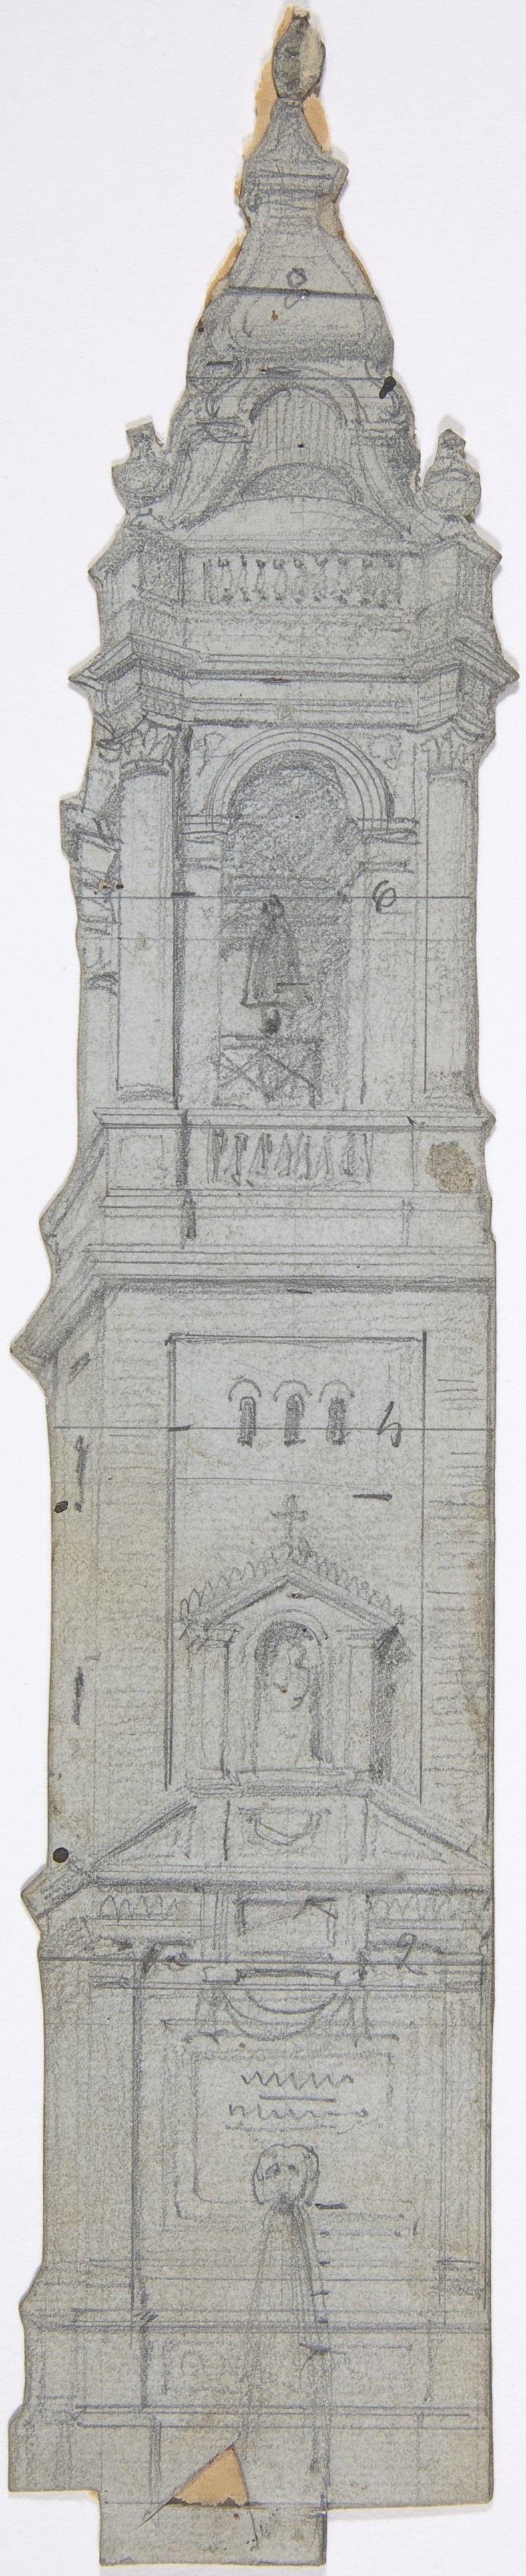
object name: drawing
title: Design for a Stage Set at the Opéra, Paris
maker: eugène cicéri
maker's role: artist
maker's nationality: french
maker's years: 1813-1890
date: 1830-1890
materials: graphite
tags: towers,stage design